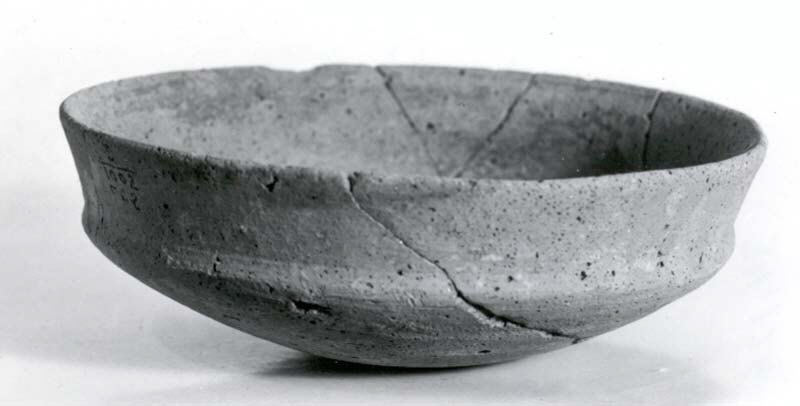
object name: bowl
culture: israelite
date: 734-601 BCE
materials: ceramic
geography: levant